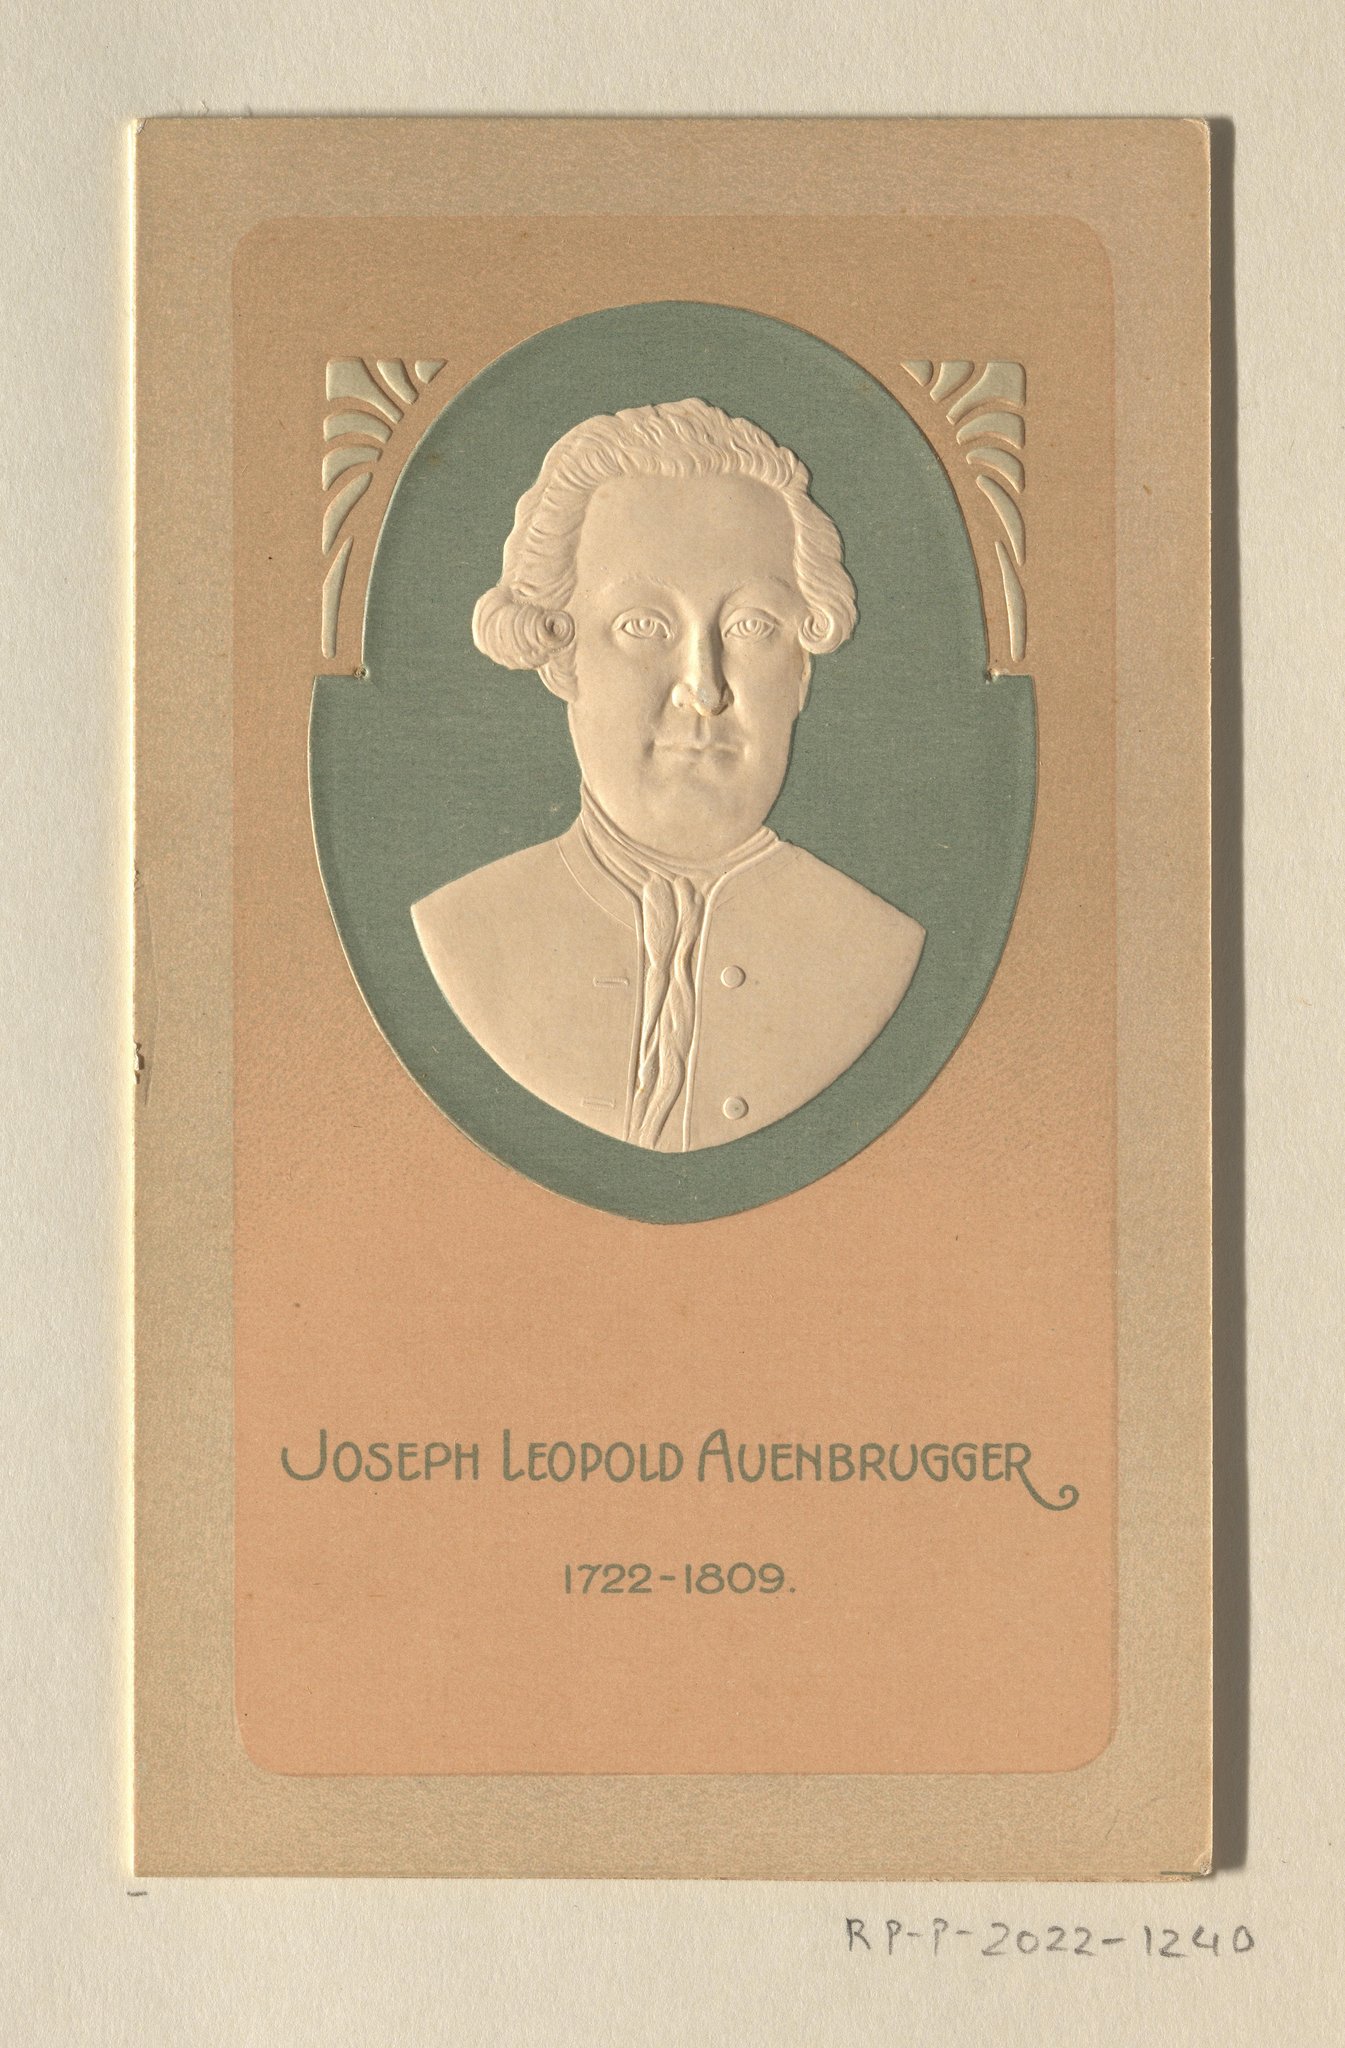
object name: print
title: Galerie berühmter Ärzte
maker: Anonymous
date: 1910-1915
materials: paper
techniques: blind stamped, lithograph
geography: germany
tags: advertising, physician, doctor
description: Kaart met portretbuste van de arts Leopold Auenbrugger. Onderdeel van de serie kaarten in reliëfdruk uitgebracht als reclame voor de medische producten van Tropon-Werke, Mülheim am Rhein.